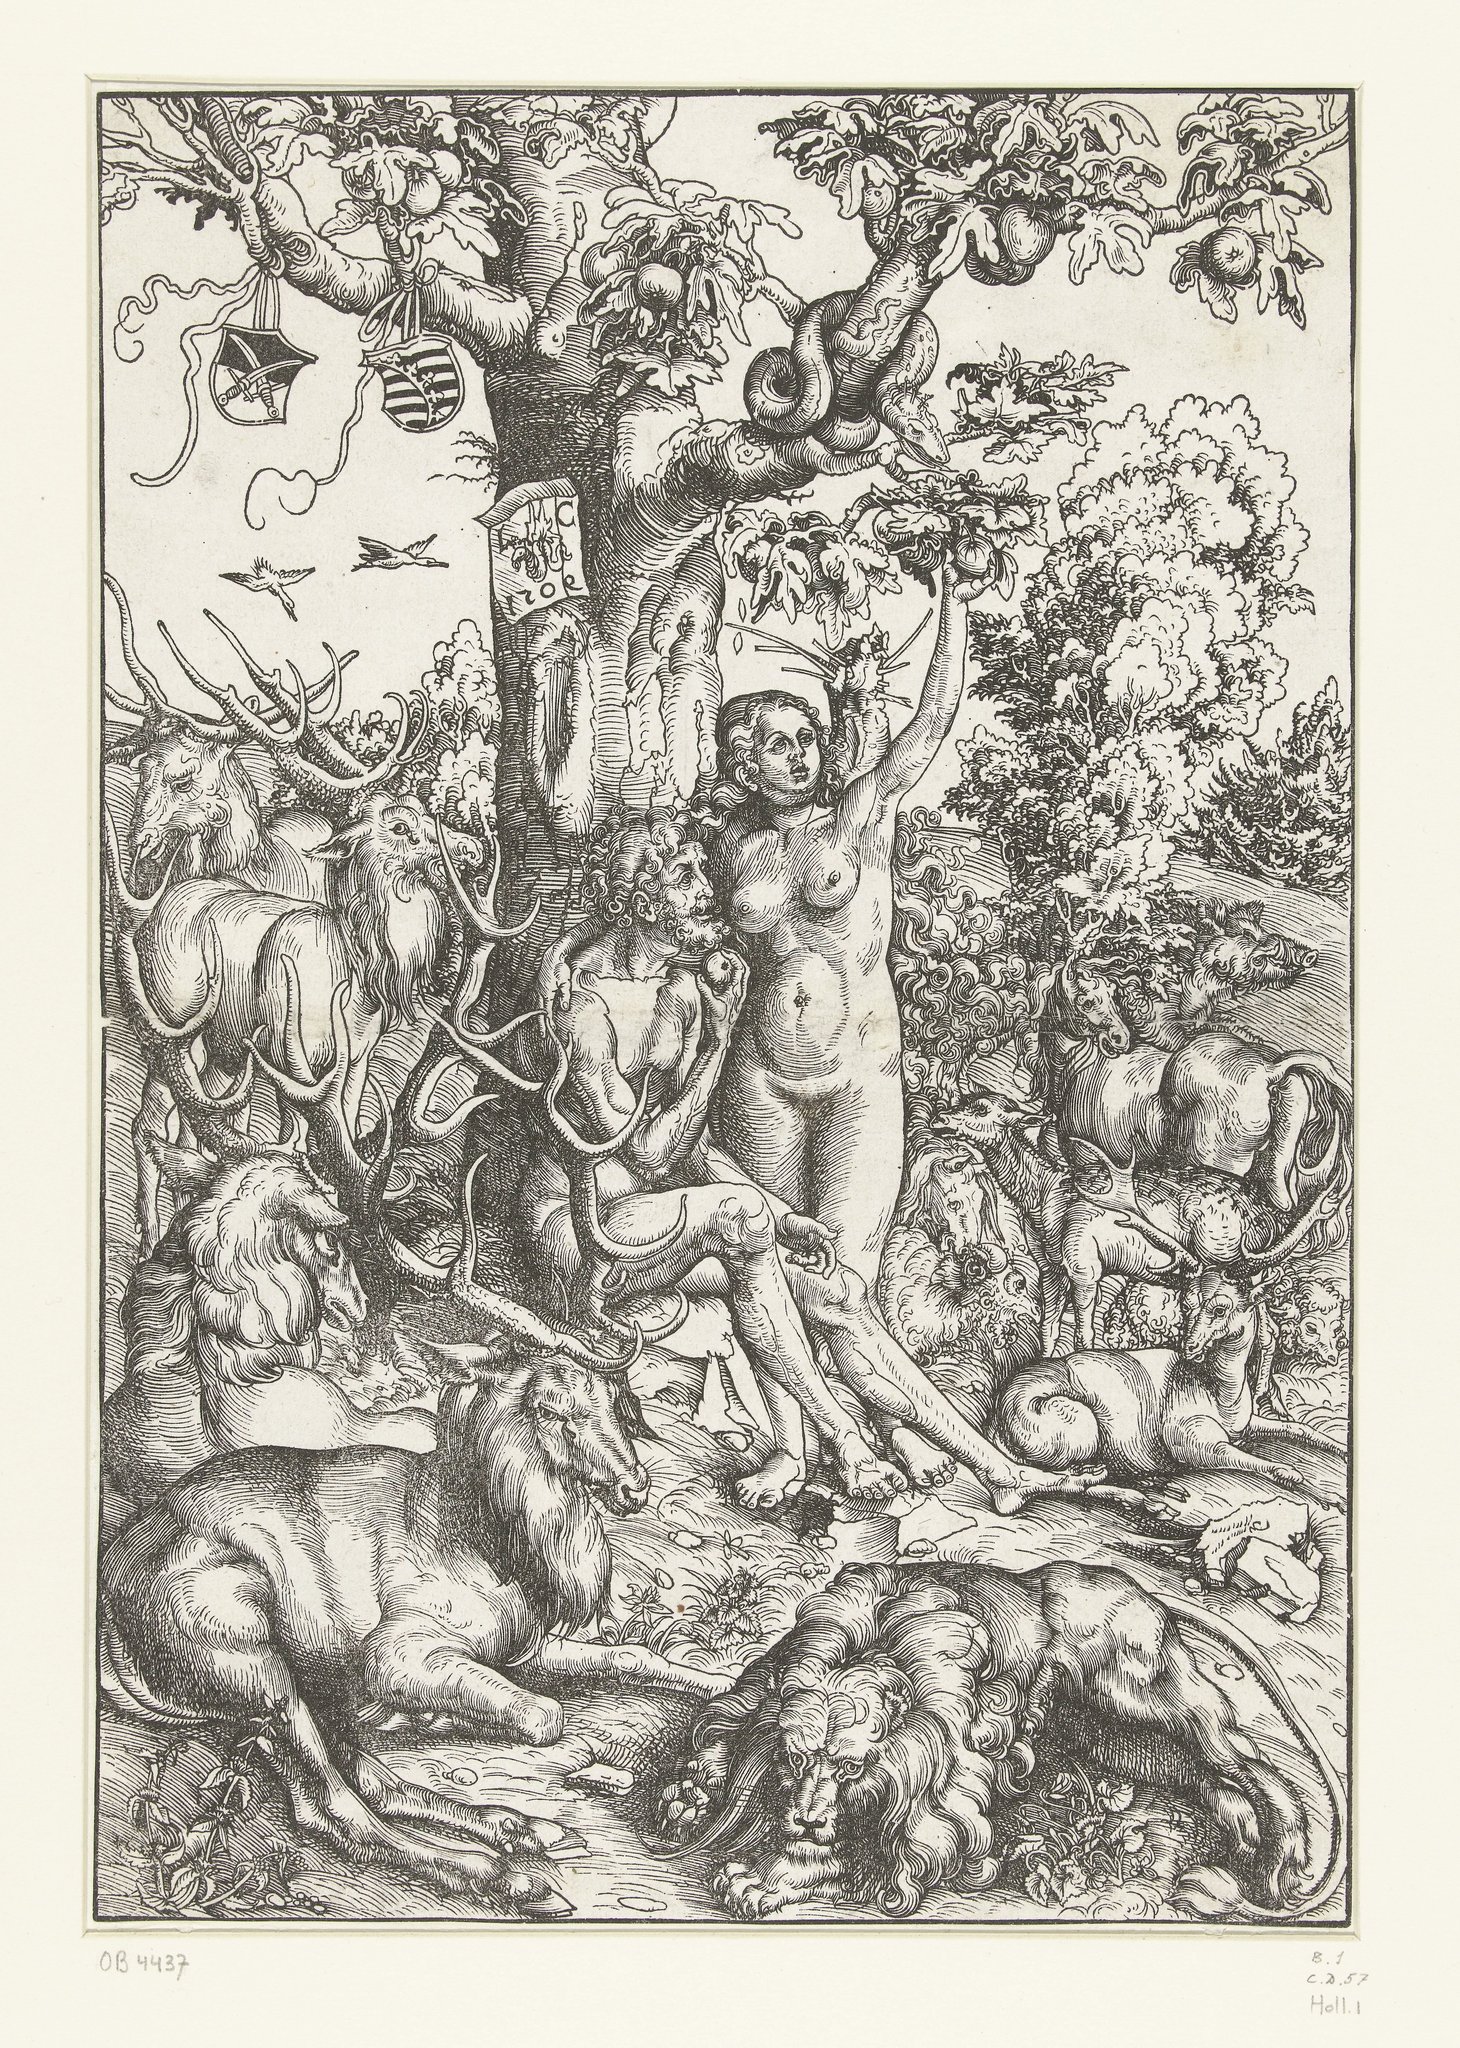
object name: print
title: Adam en Eva omringd door dieren in paradijs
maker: lucas cranach (i)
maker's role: draughtsman, print maker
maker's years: 1472-1553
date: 1509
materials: paper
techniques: woodcut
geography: germany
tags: eve takes the fruit from the serpent (or the tree) in the presence of adam (who may be trying to stop her)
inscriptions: collector's mark: Lugt 240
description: Eva plukt een appel uit de boom der kennis van goed en kwaad. Adam zit naast haar onder de boom met een appel in zijn hand. De slang krult zich rond een tak. Rond de boom liggen en staan dieren waaronder edelherten met grote geweien maar ook een leeuw. Rechtsachter worden een hert en een hinde vergezeld van paarden, schapen en een zwijn. Linksboven aan de tak van een boom hangen twee schilden met het keurvorstelijk en hertogelijk wapen van Saksen.